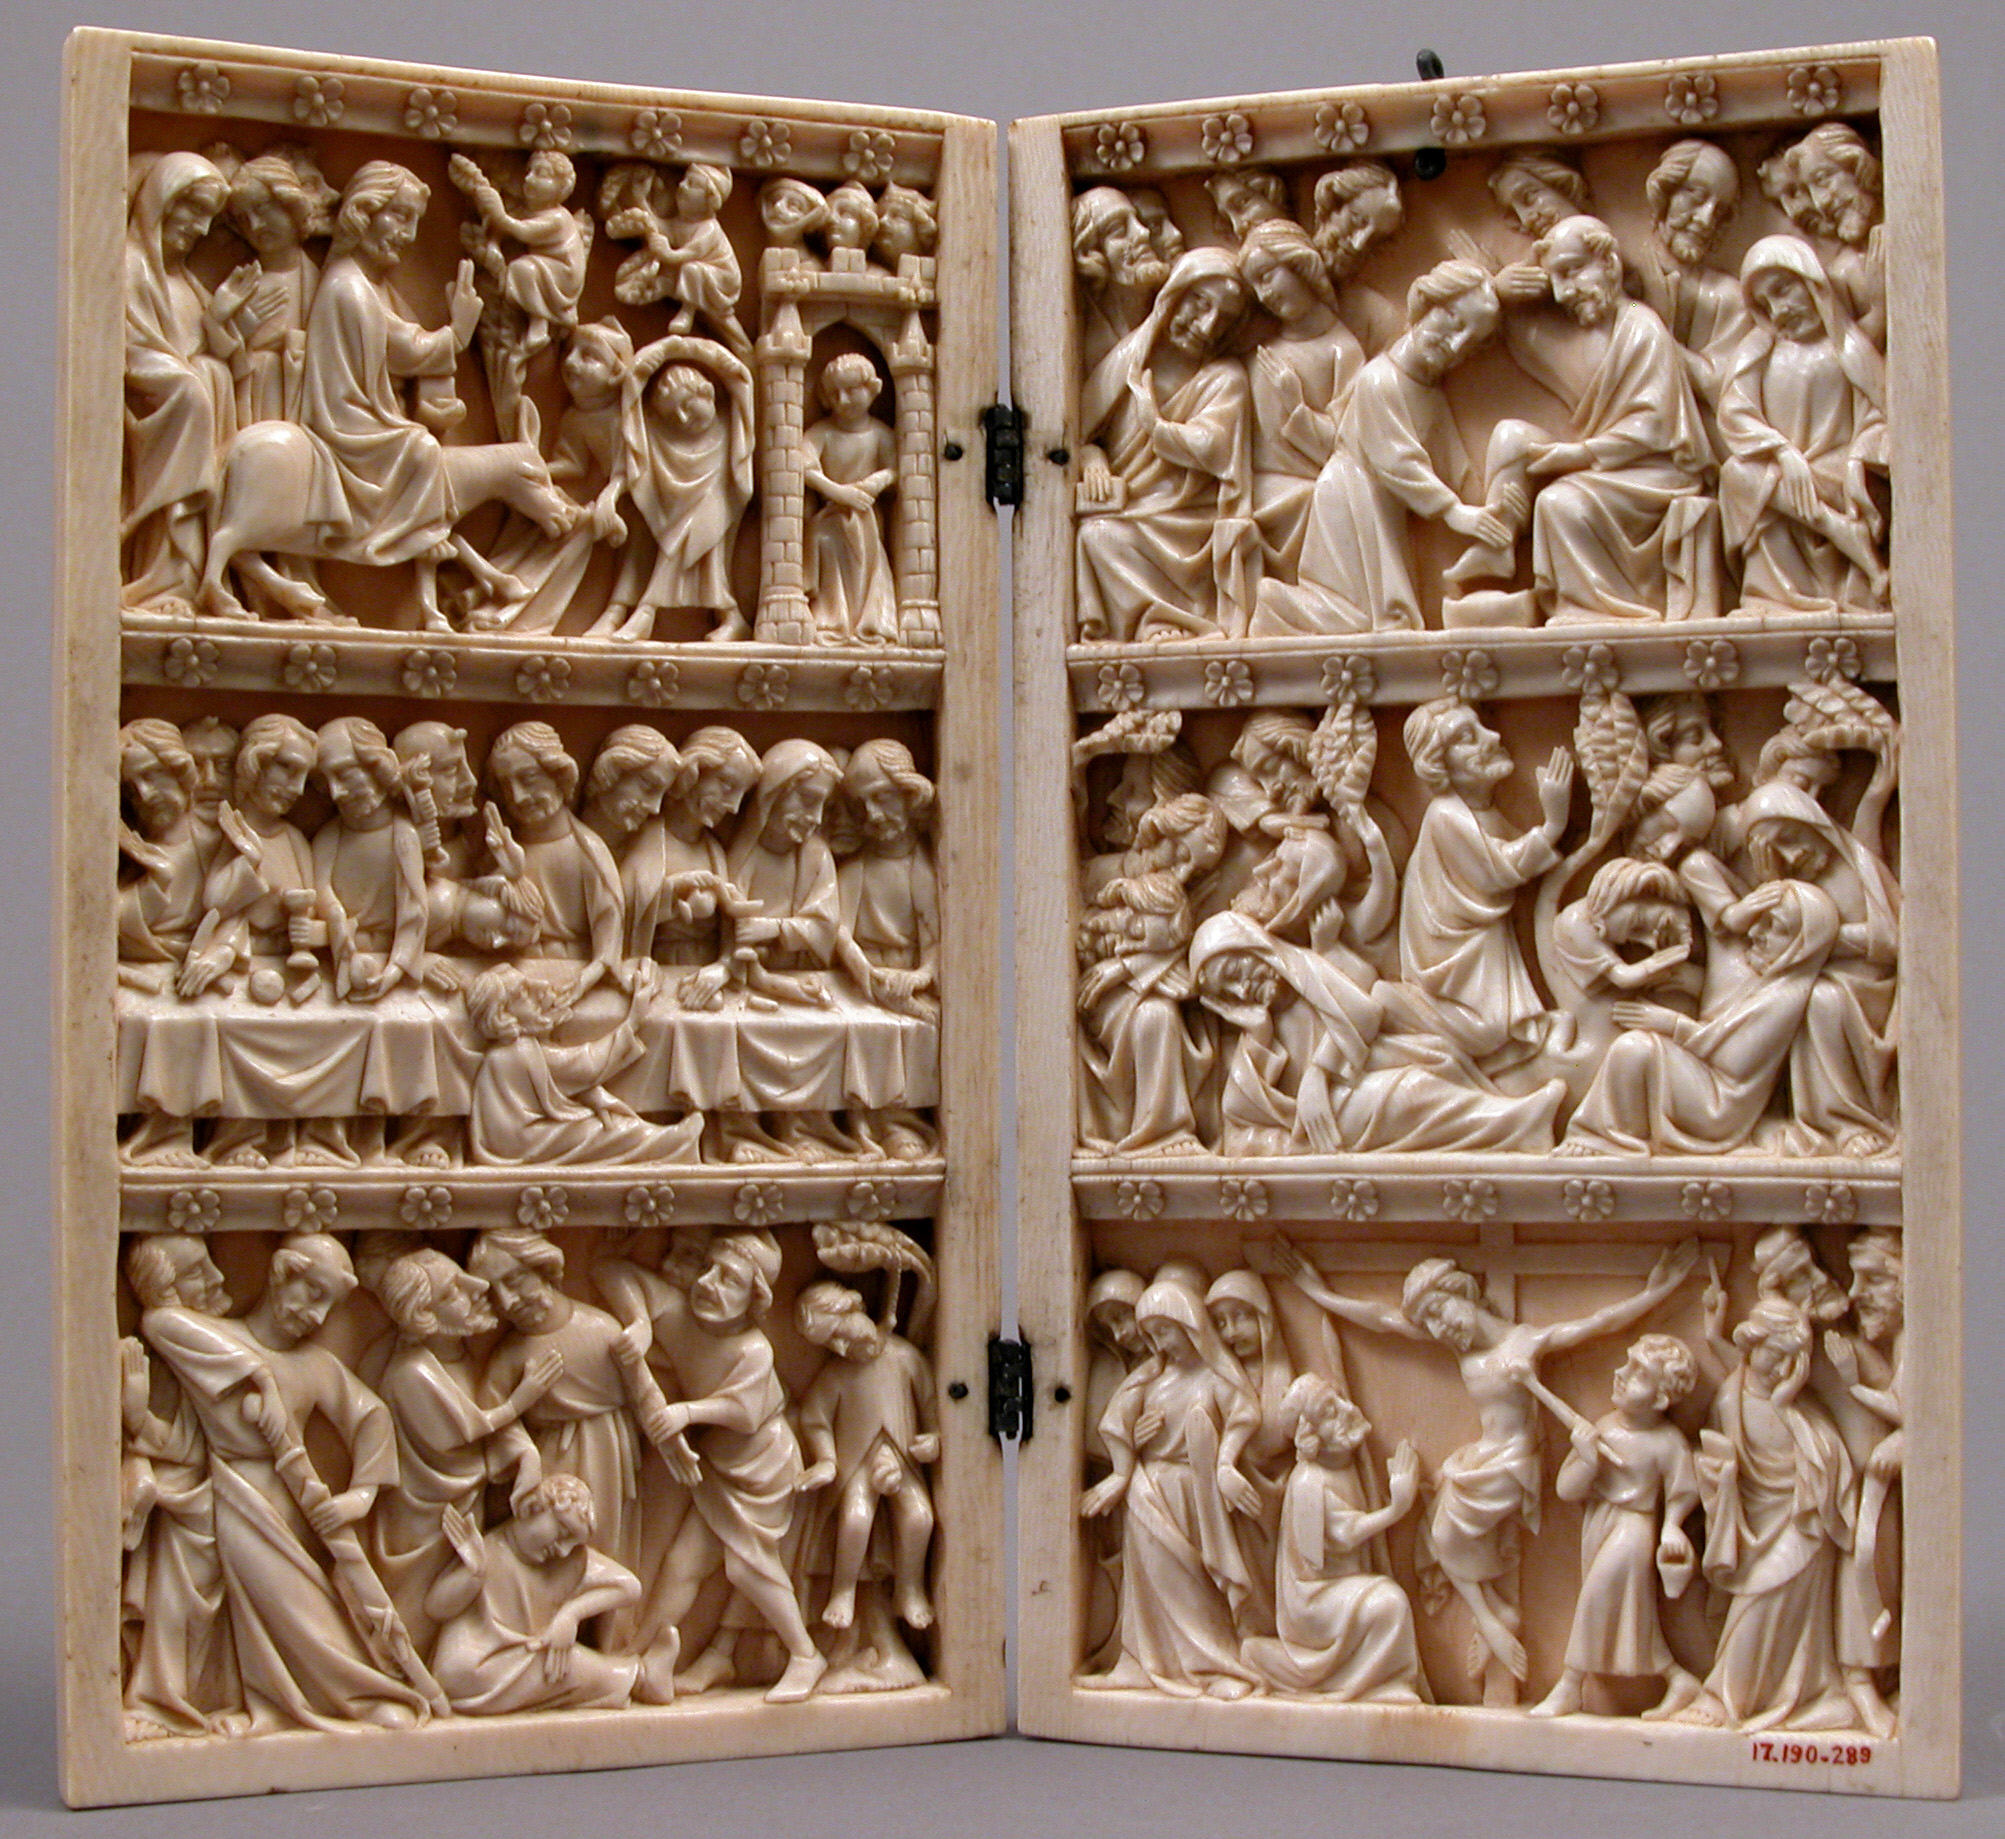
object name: diptych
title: Diptych with Scenes from the Passion of Jesus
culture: french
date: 1350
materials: ivory, metal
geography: france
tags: men,donkeys,christ,judas,crucifixion,last supper